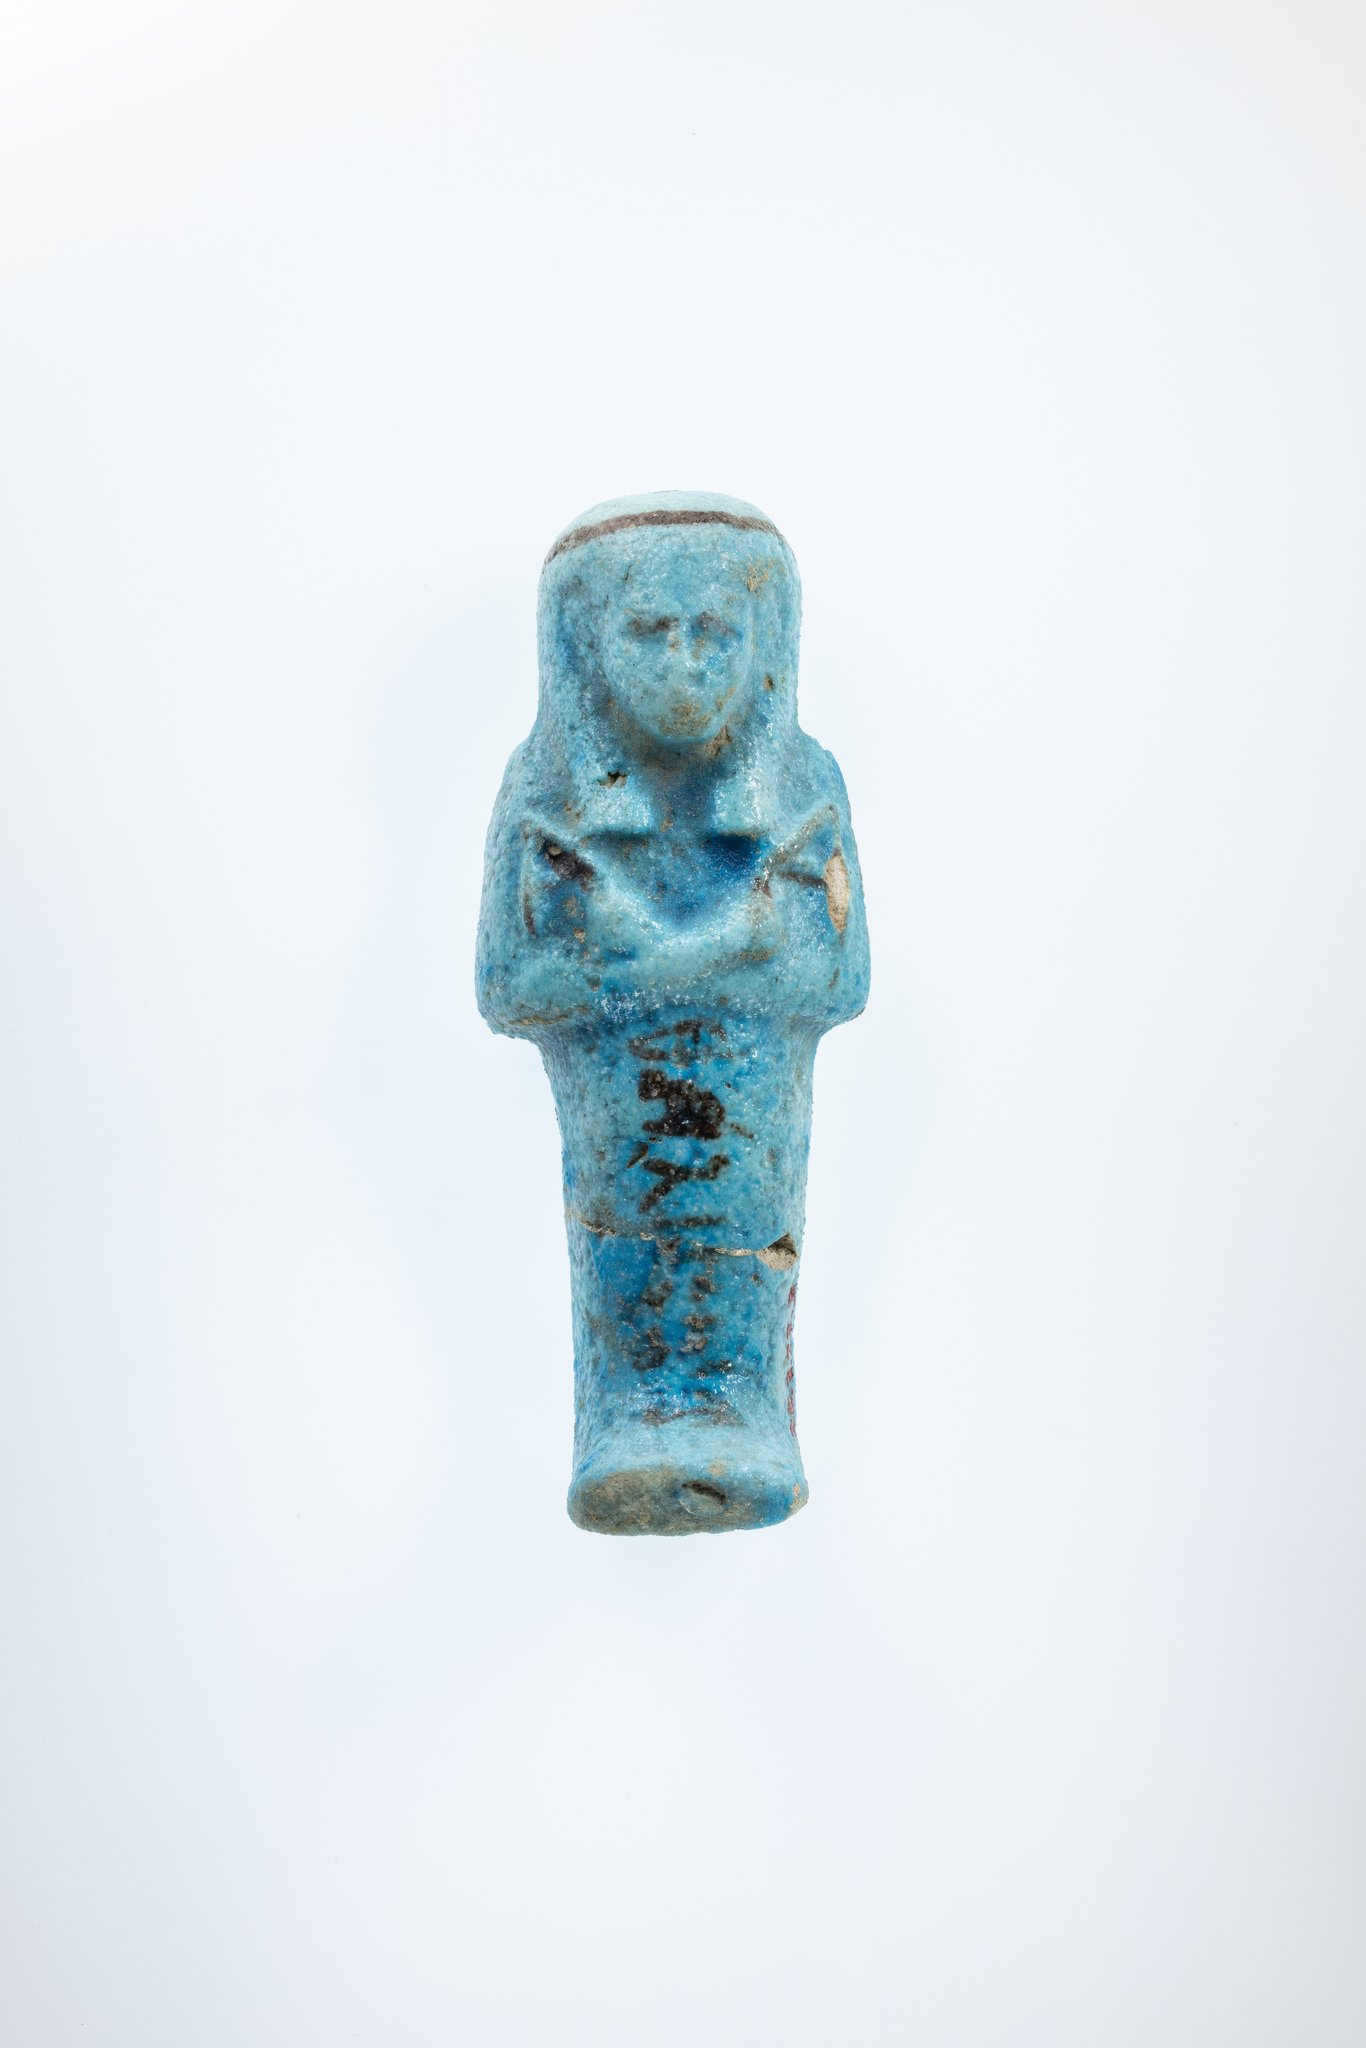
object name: shabti, nesenaset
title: Shabti of Nesenaset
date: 1070-945 BCE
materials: faience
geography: egypt